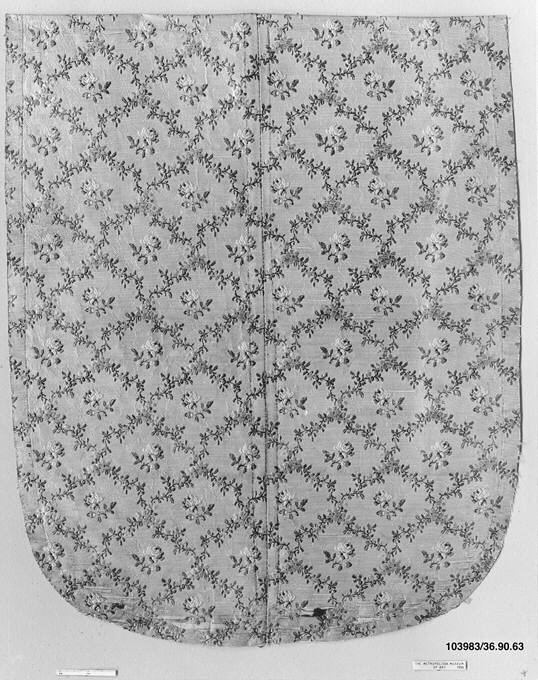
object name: piece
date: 1770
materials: metal thread, silk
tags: flowers,leaves